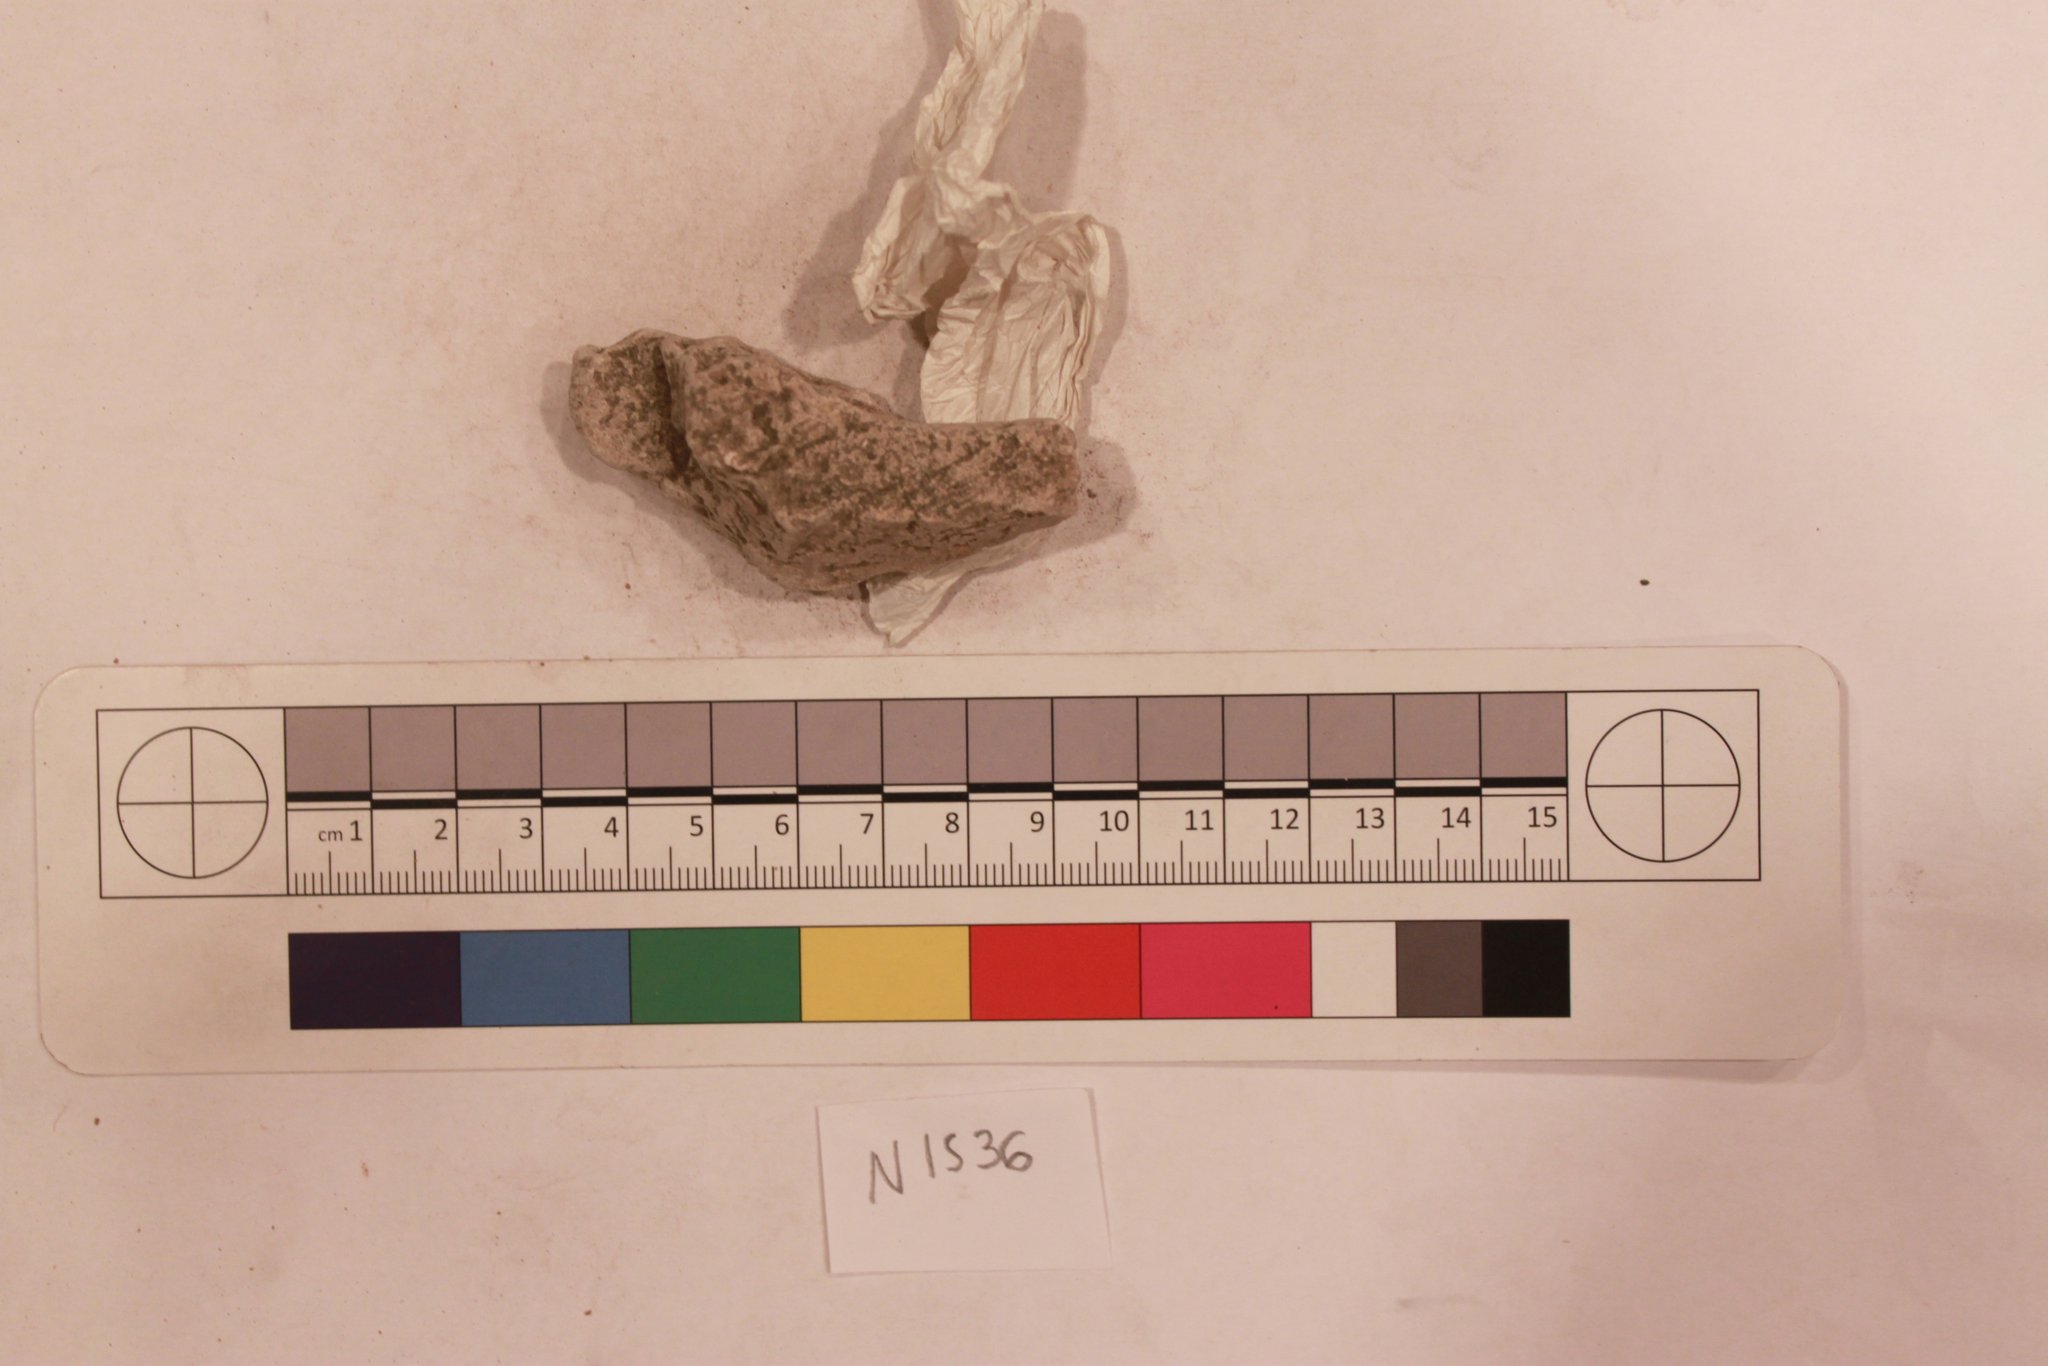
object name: fragment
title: Stucco Fragment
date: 701-1200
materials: plaster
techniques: carving, painting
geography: iran